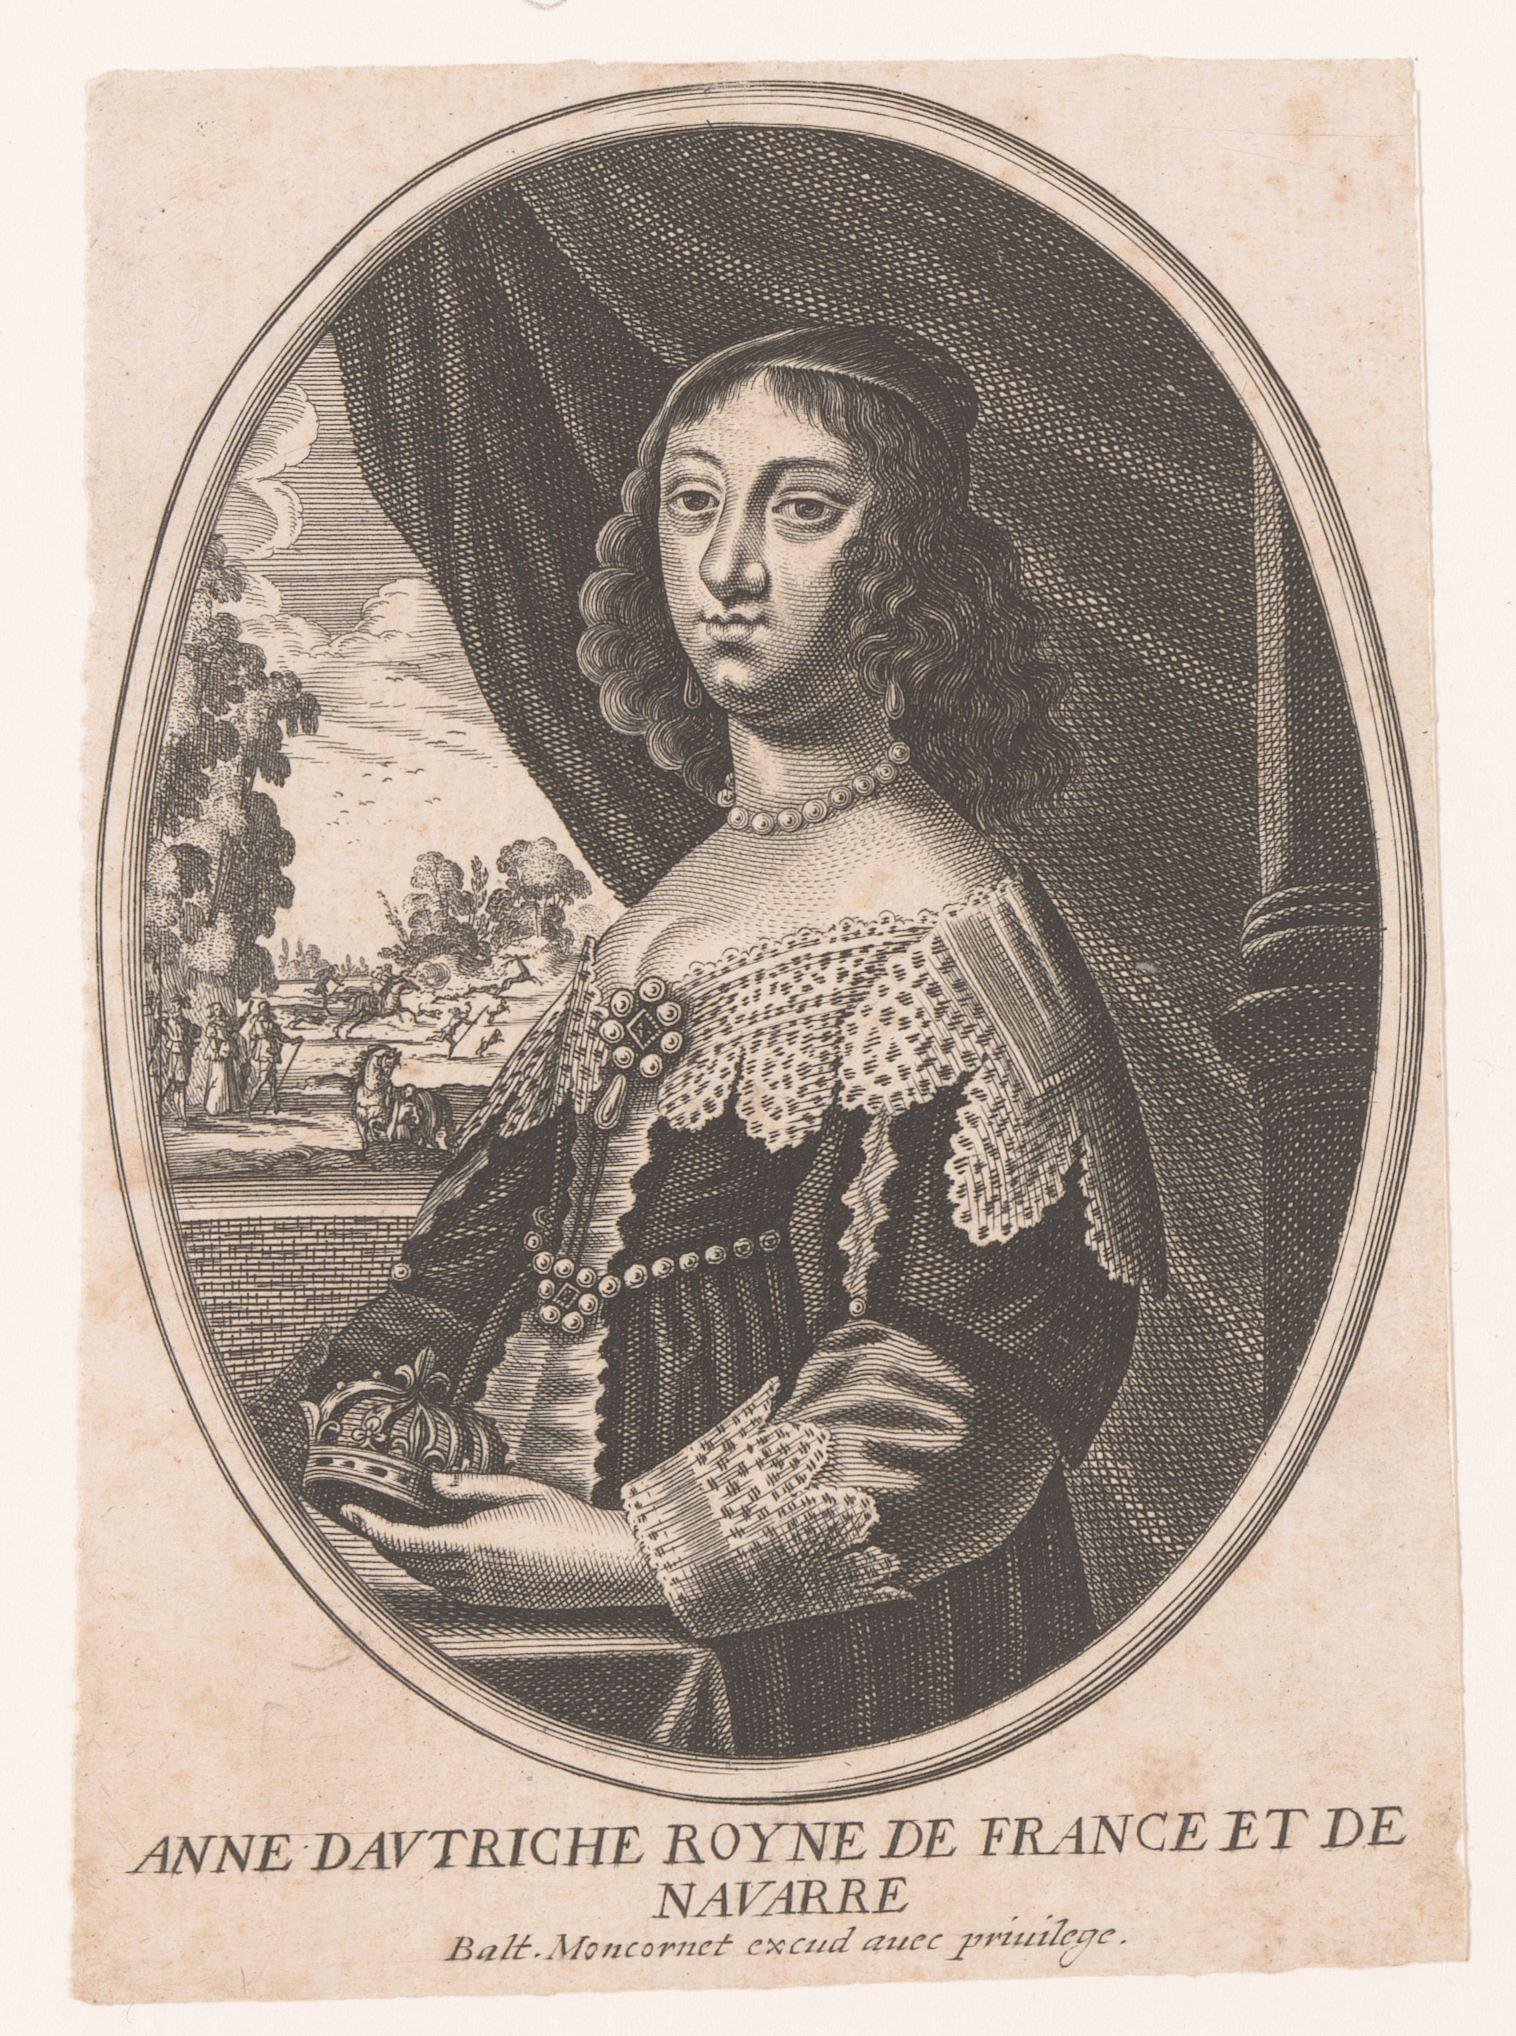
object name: print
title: Portret van Anna van Oostenrijk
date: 1610-1668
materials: paper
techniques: engraving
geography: paris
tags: paris, anna van oostenrijk (koningin van frankrijk), historical persons - bb - woman, ruler, sovereign - bb - female ruler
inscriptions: collector's mark: Lugt 2228